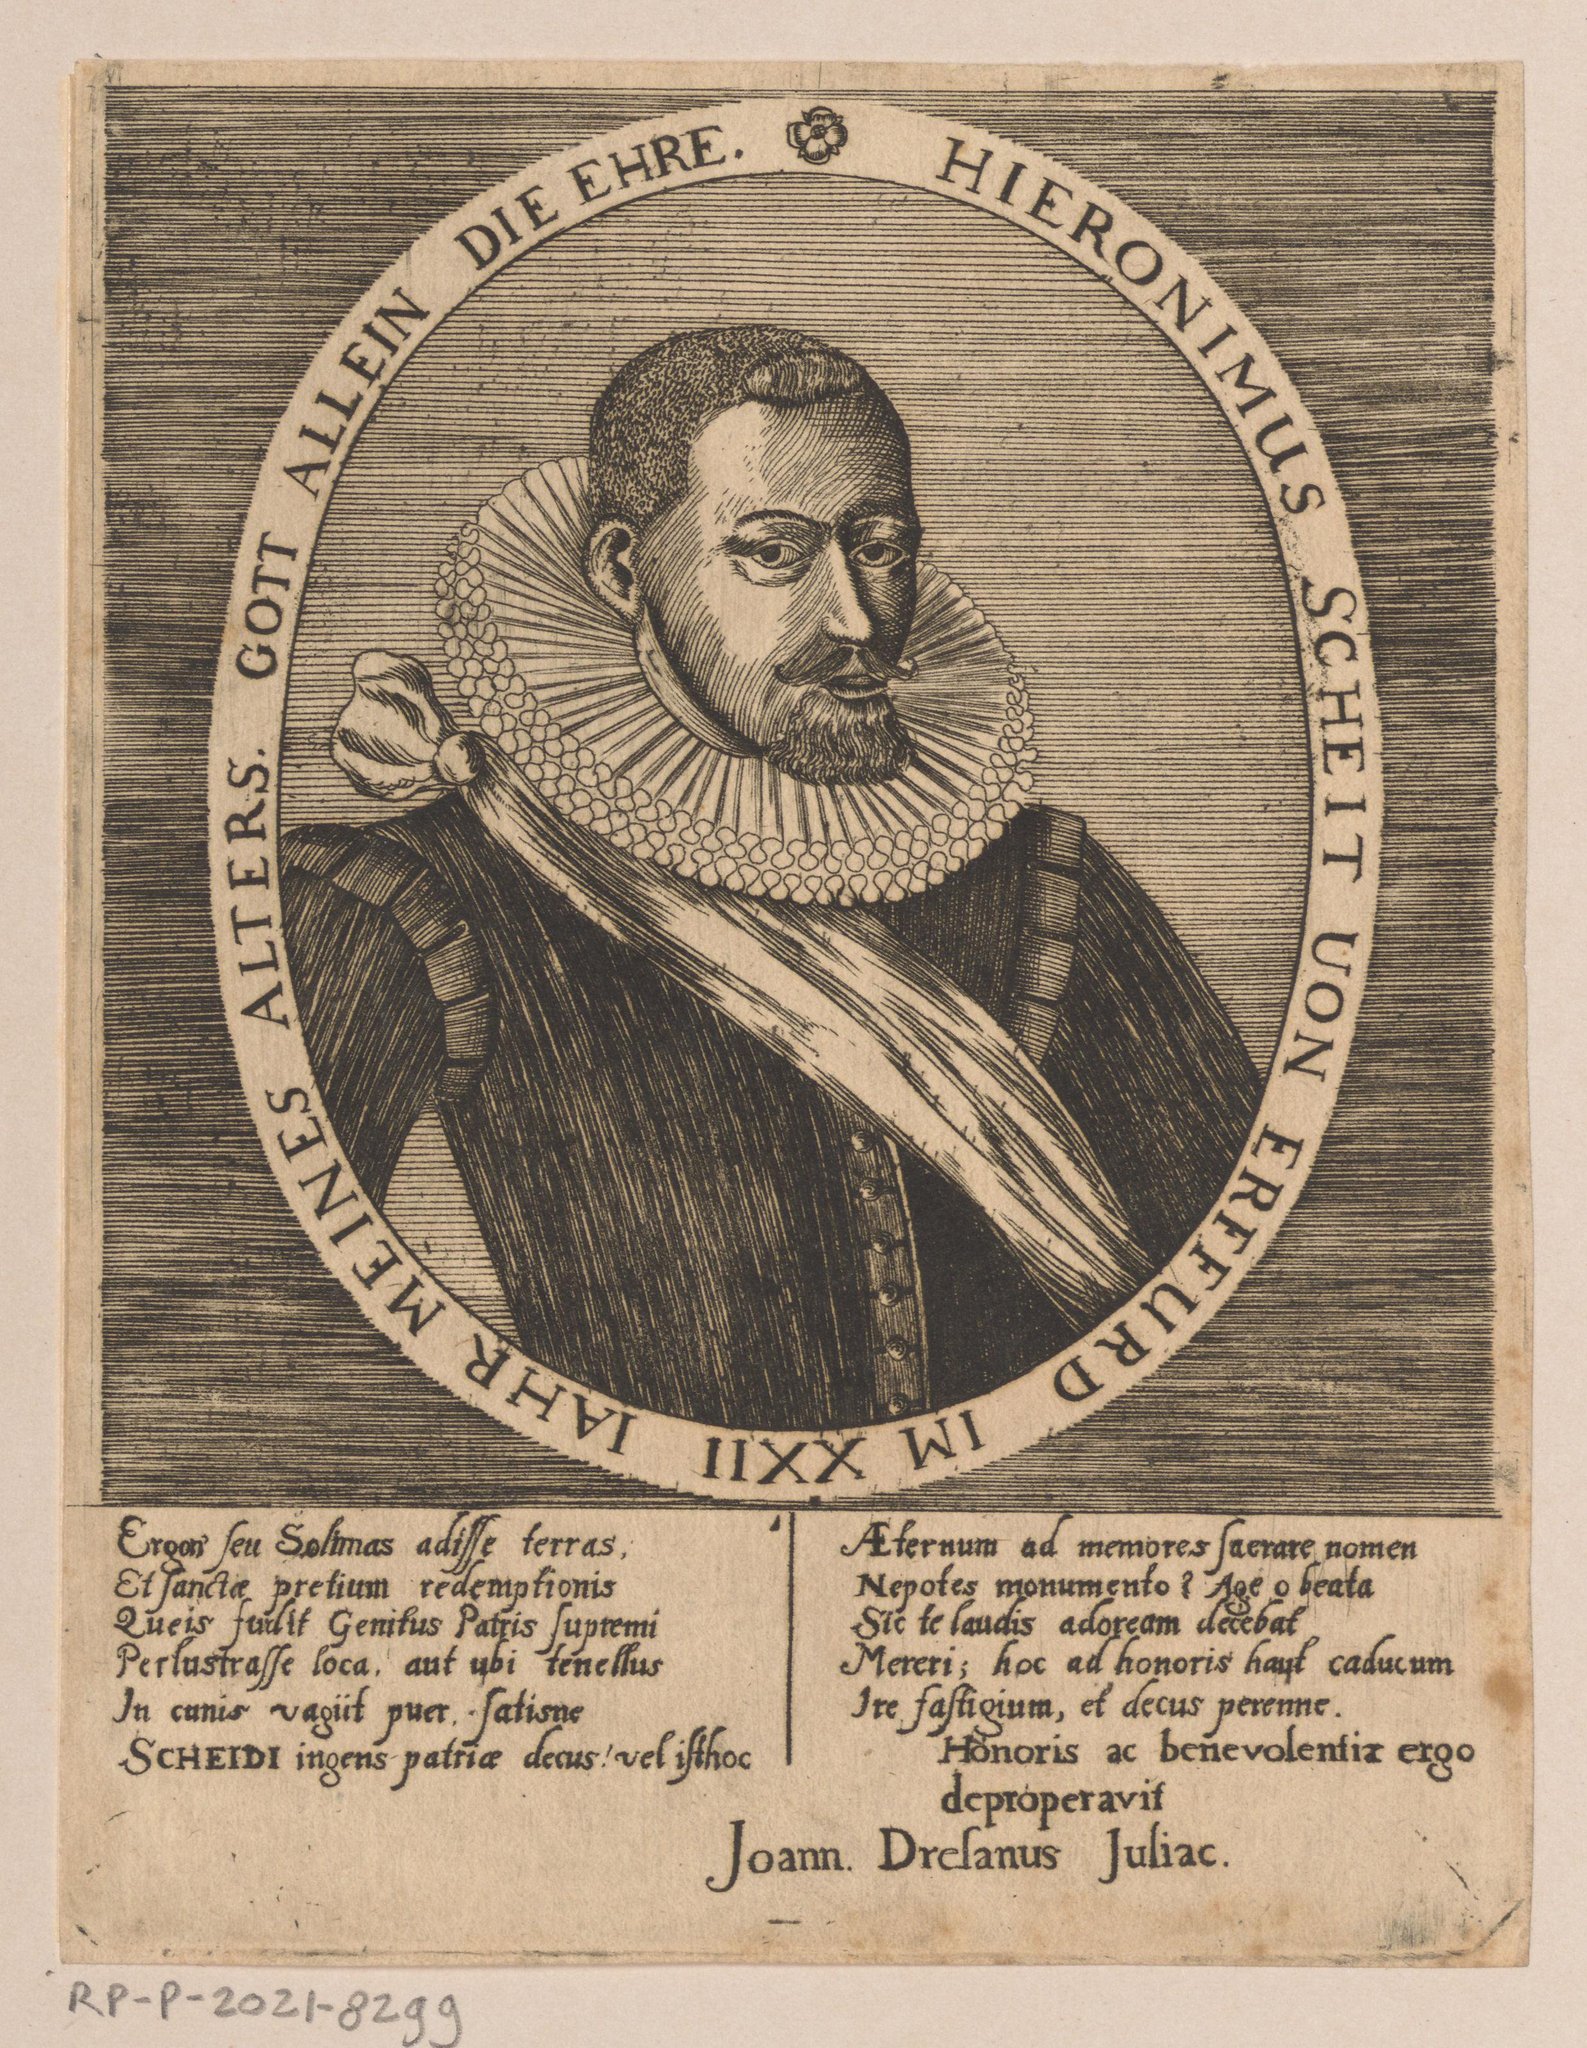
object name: print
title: Portret van Hieronymus Scheidt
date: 1679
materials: paper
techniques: etching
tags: pilgrim(s), historical persons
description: Prent waarschijnlijk uit: Scheidt, Hieronymus. Kurtze und warhafftige Beschreibung der Reise von Erffürdt aus Thüringen nach dem gewesenen gelobten Lande (...). Helmstedt: Paul Zeising, 1679.